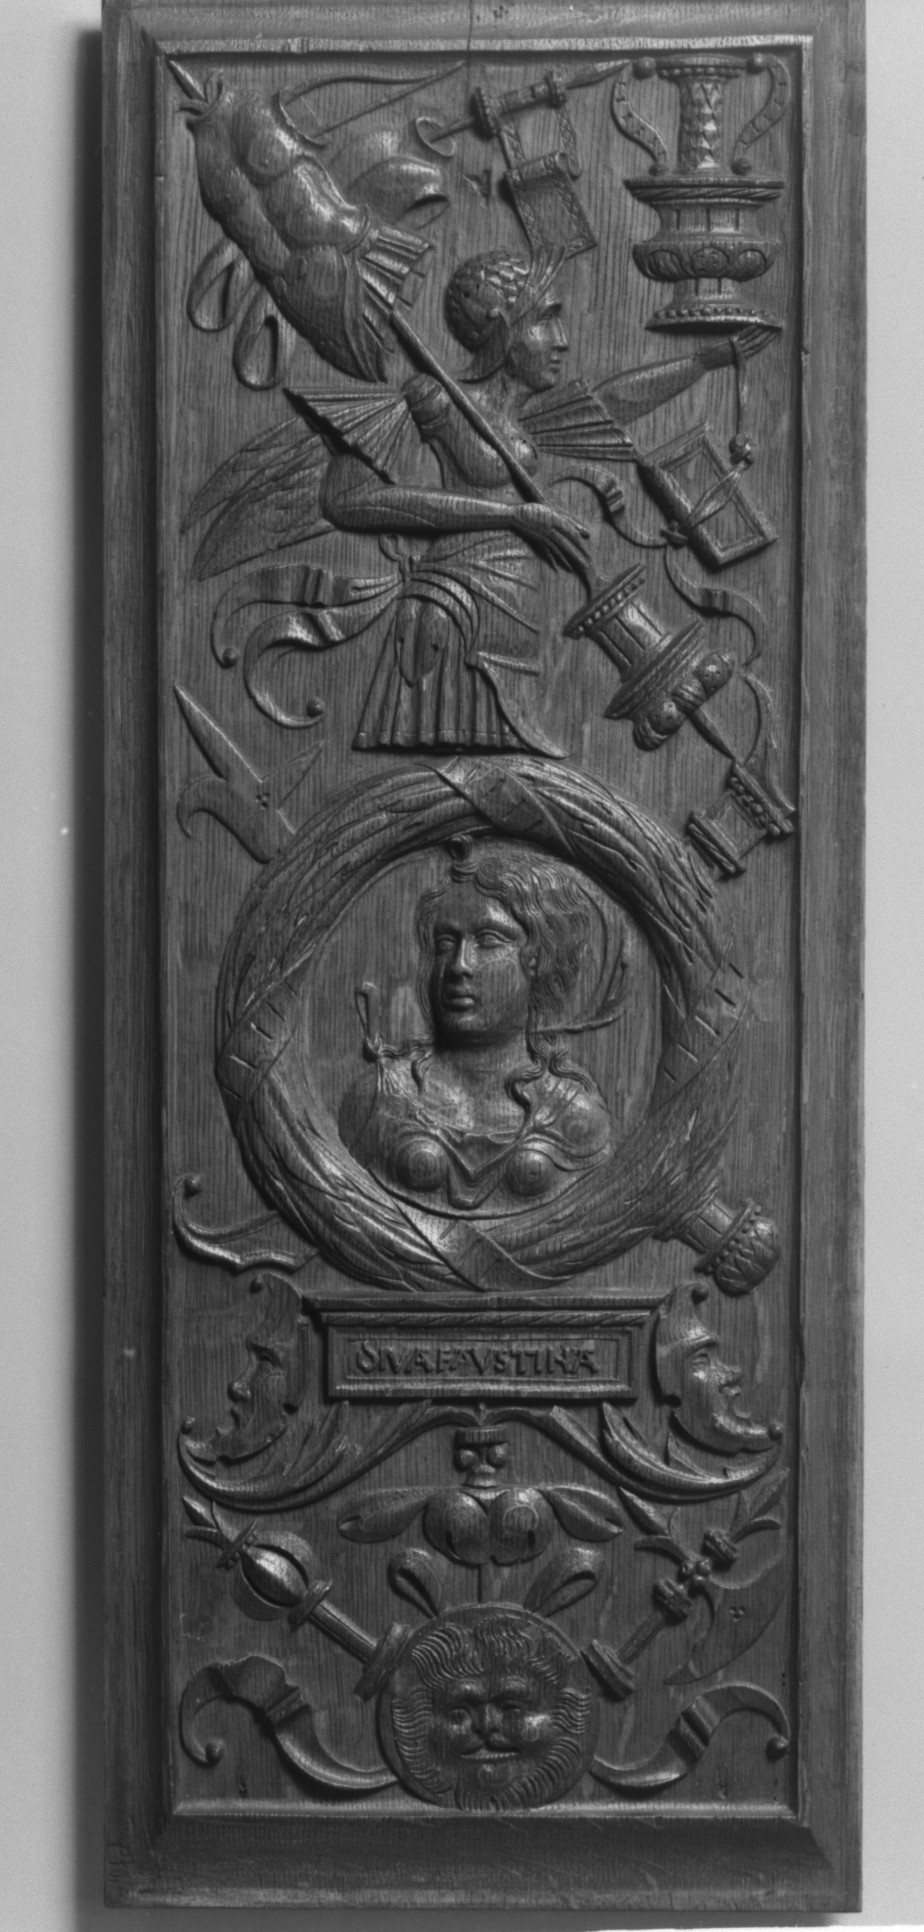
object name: panel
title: Panel (part of a set)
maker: nicolas castille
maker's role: maker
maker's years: 1503-1521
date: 1510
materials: wood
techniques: carving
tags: bow and arrow,men,portraits,women